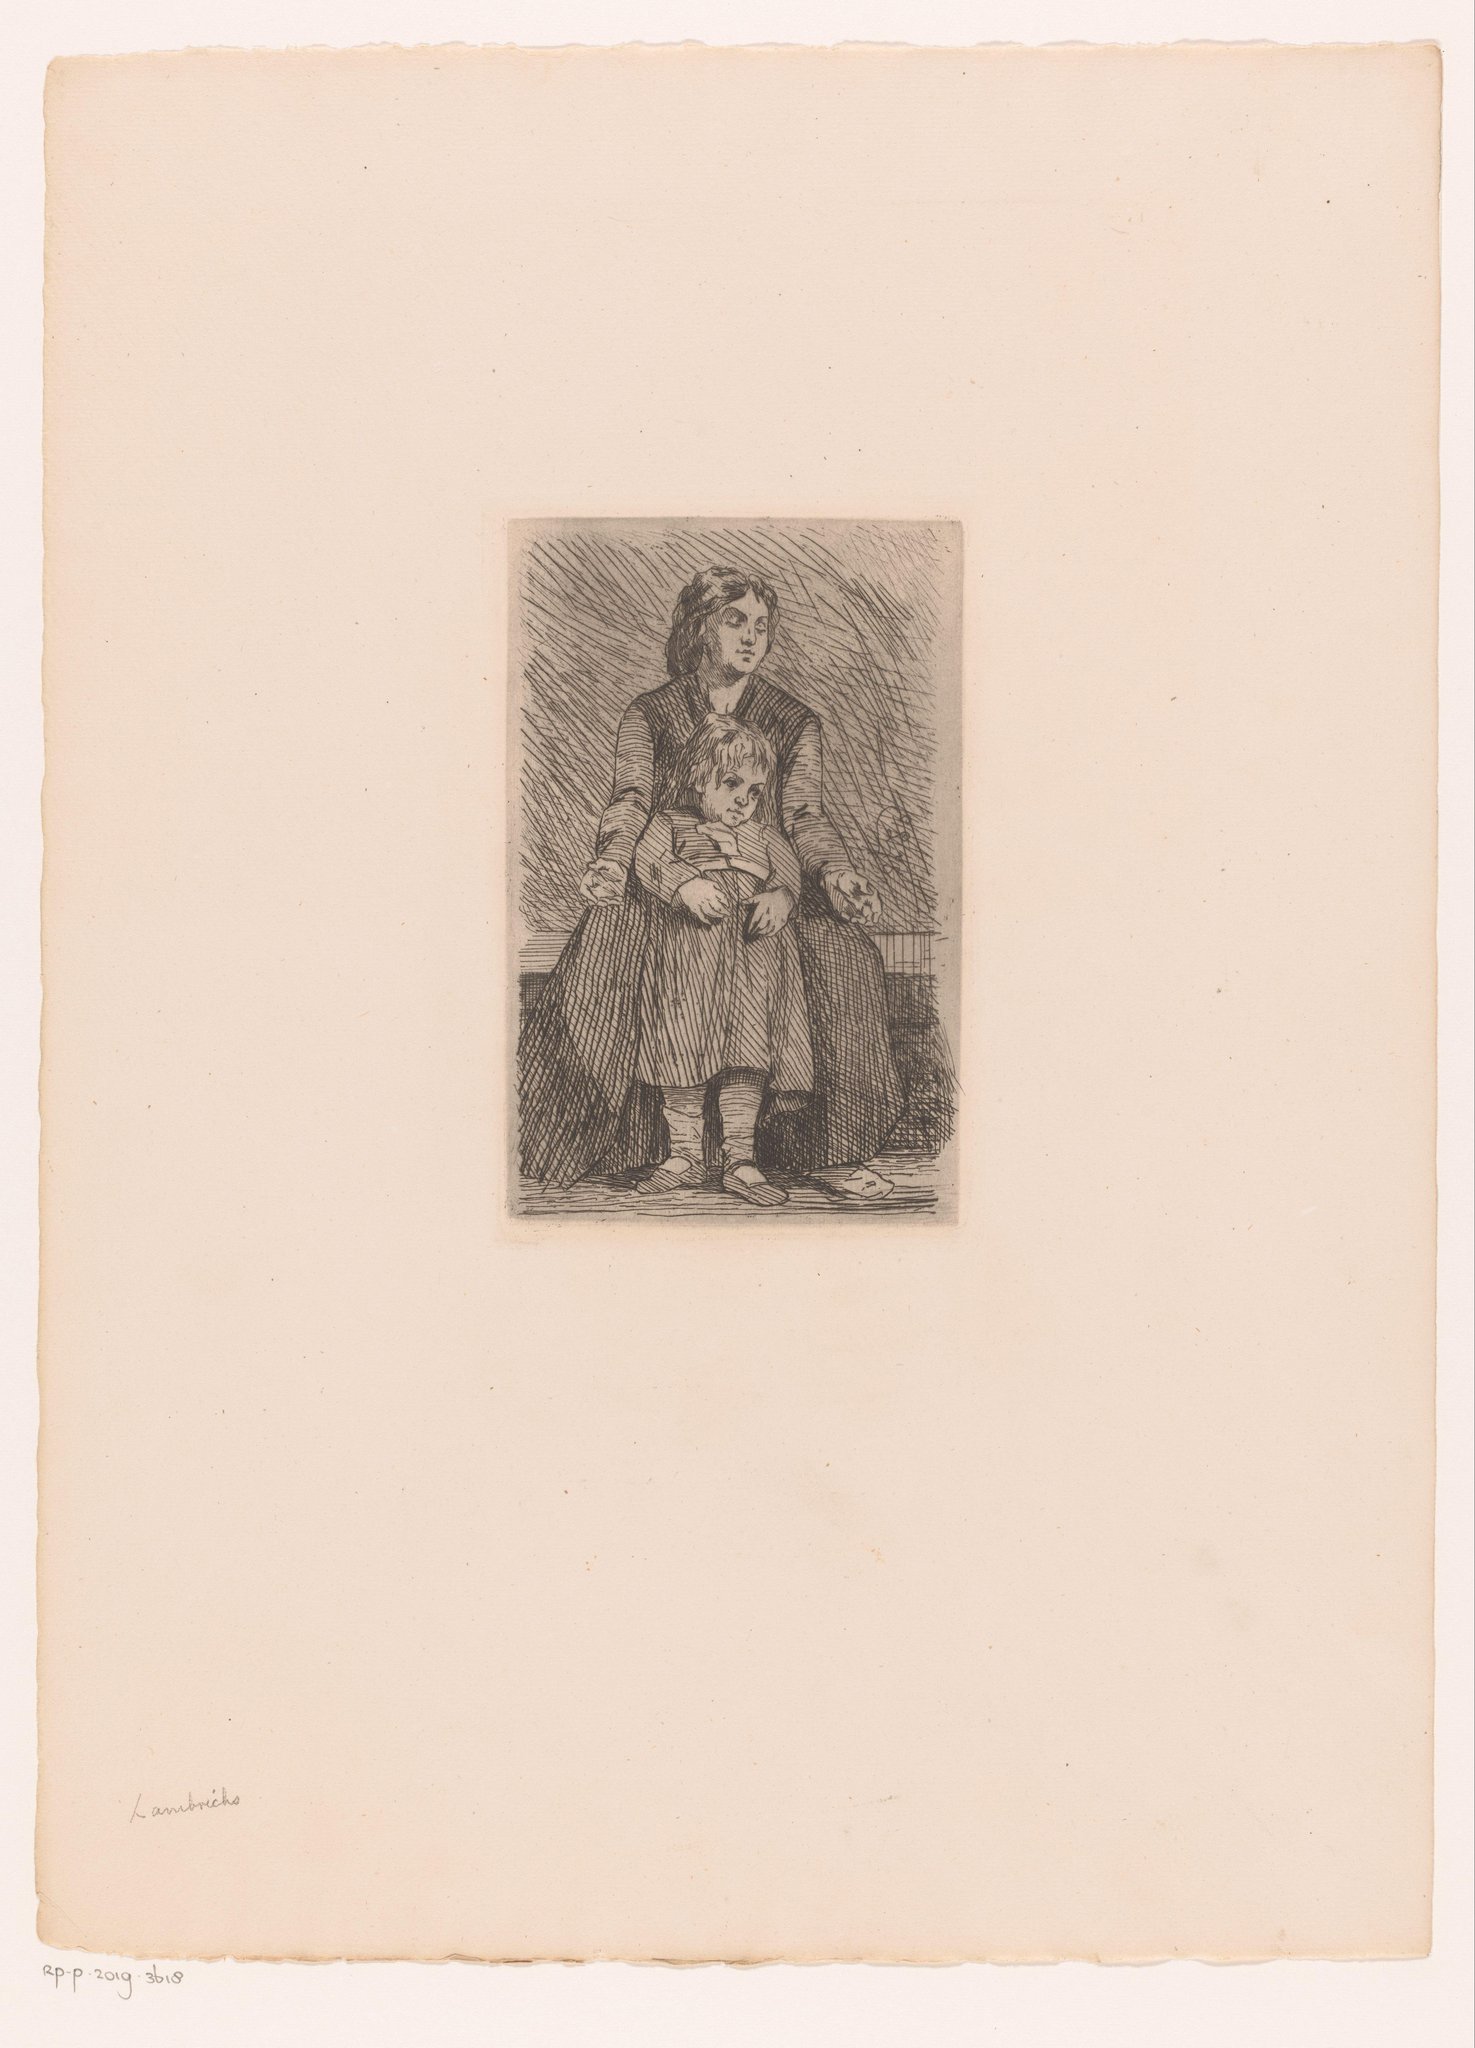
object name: print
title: Blinde vrouw met kind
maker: edmond lambrichs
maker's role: print maker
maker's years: 1830-1887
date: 1875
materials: paper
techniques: etching, intaglio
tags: mother and baby or young child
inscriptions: collector's mark: Lugt 2228